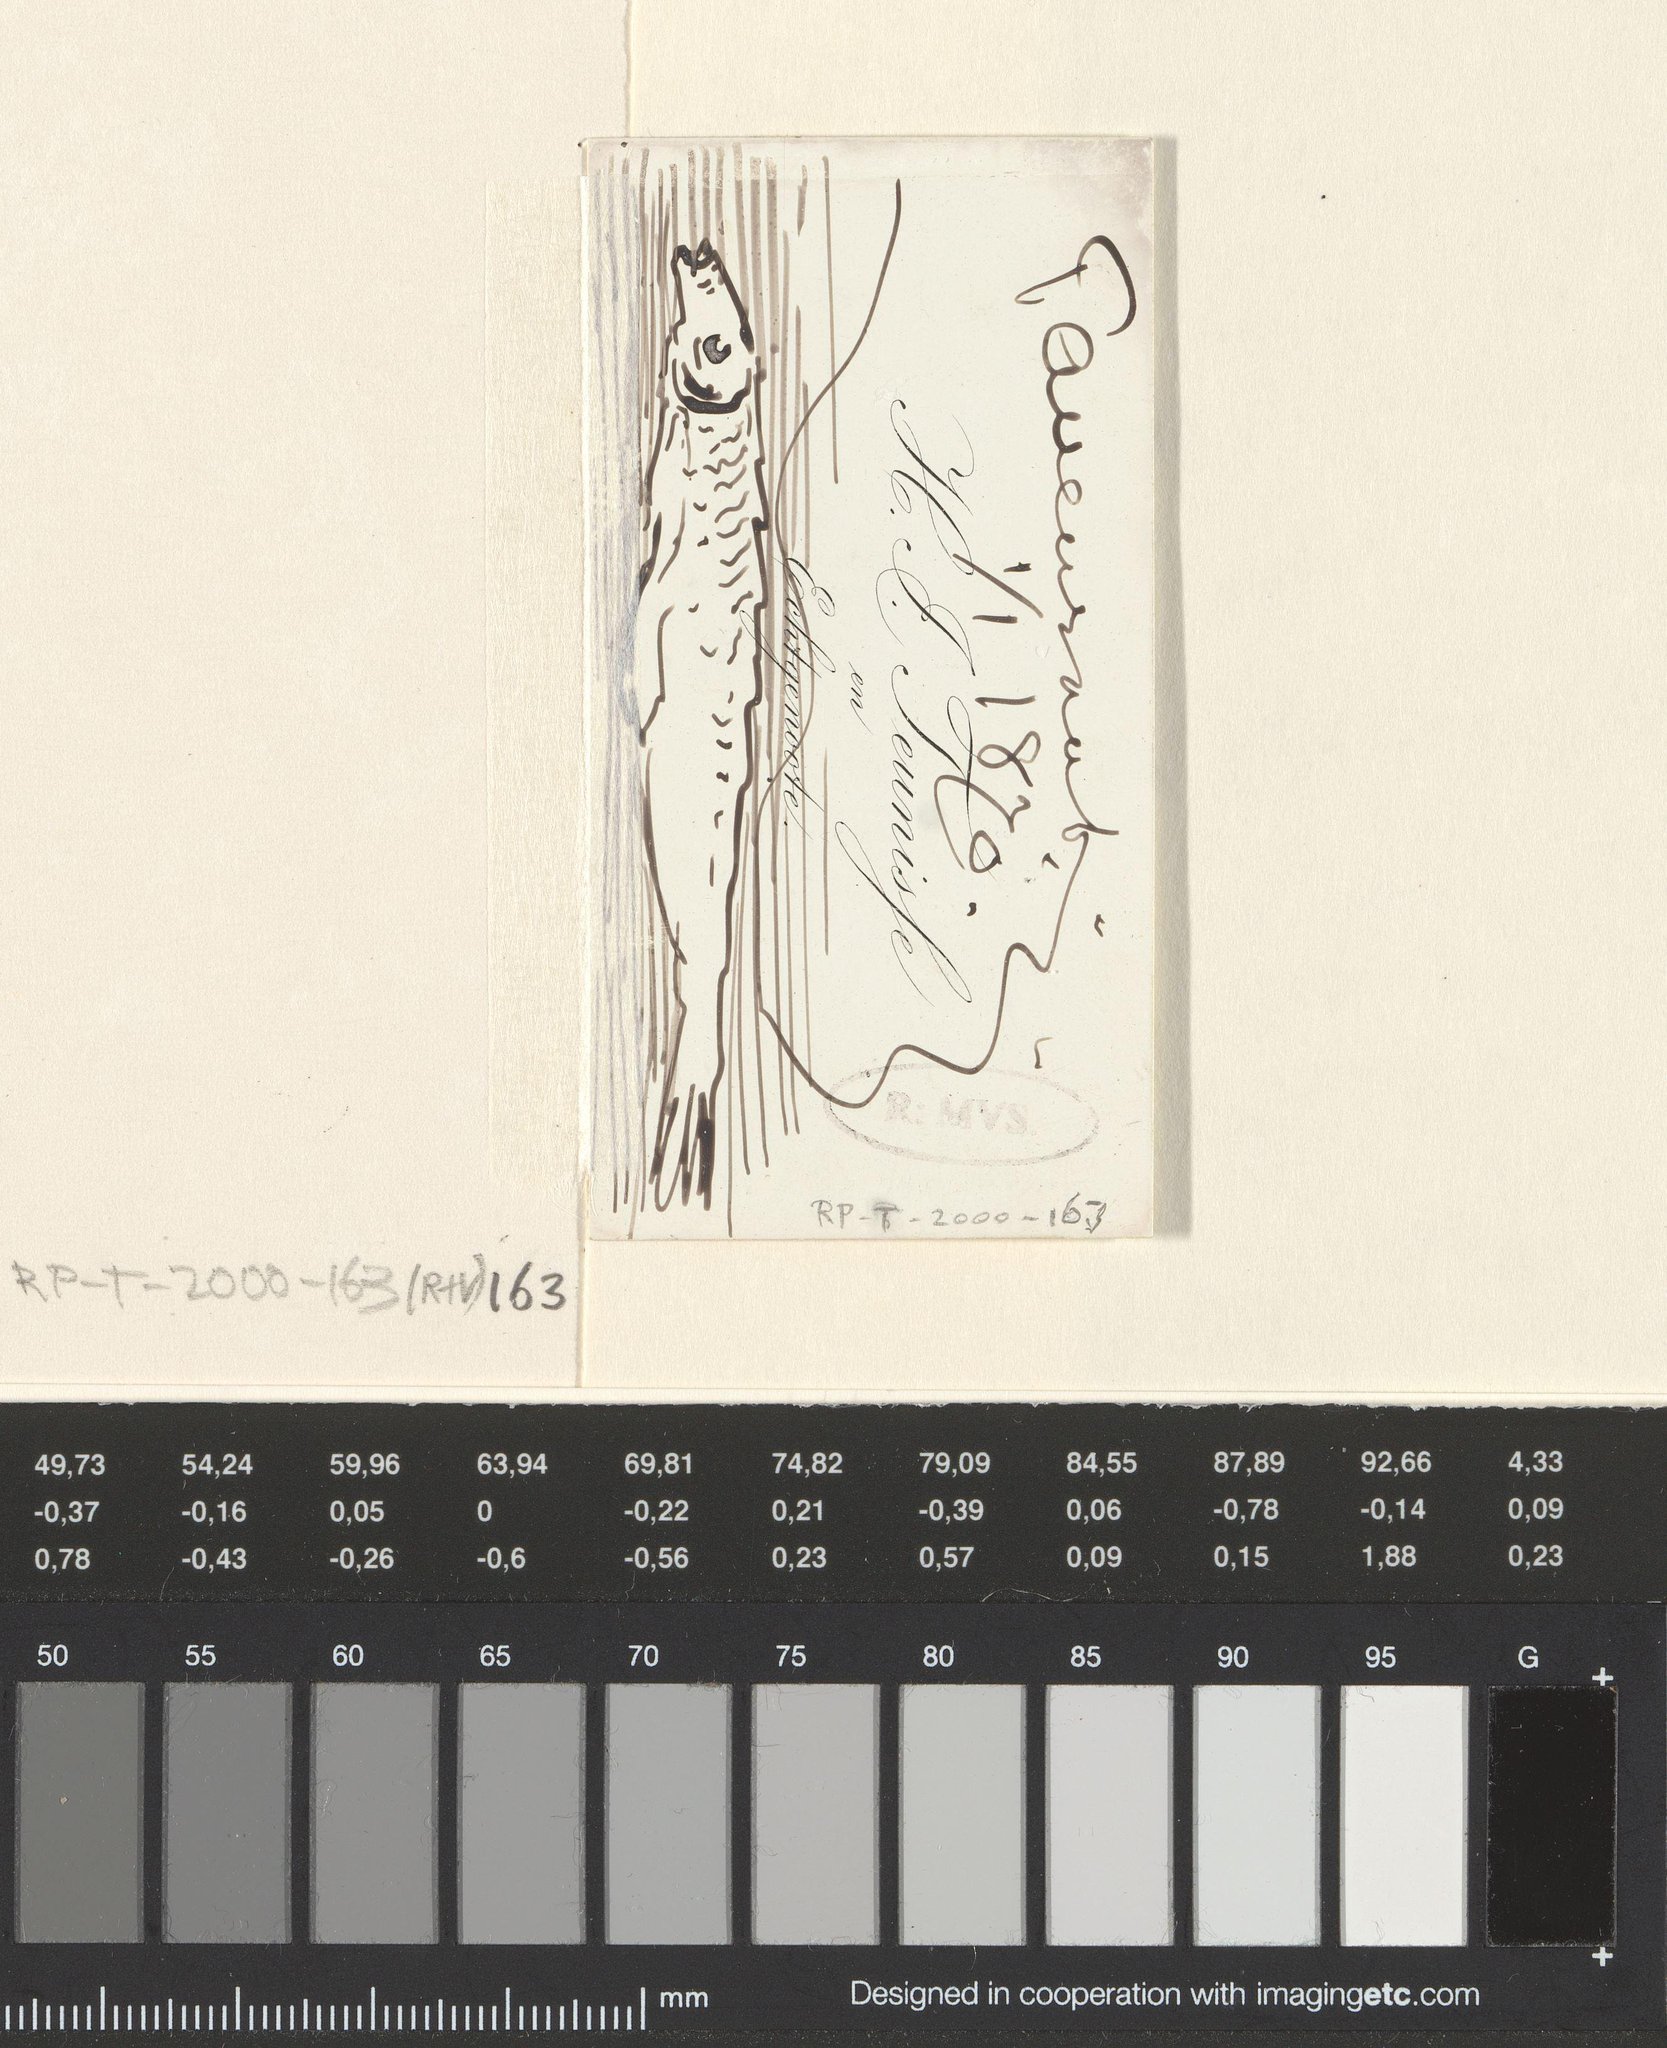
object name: visiting card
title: Vis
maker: johannes tavenraat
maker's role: draughtsman, painter, print maker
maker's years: 1809-1881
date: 1870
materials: ink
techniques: pen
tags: fishes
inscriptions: collector's mark: Lugt 2228, signature and date: ‘Tavenraat - 1/1 1870’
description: Vis in het water, getekend op het visitekaartje van: 'H.J. Teunisse en Echtgenoote'.